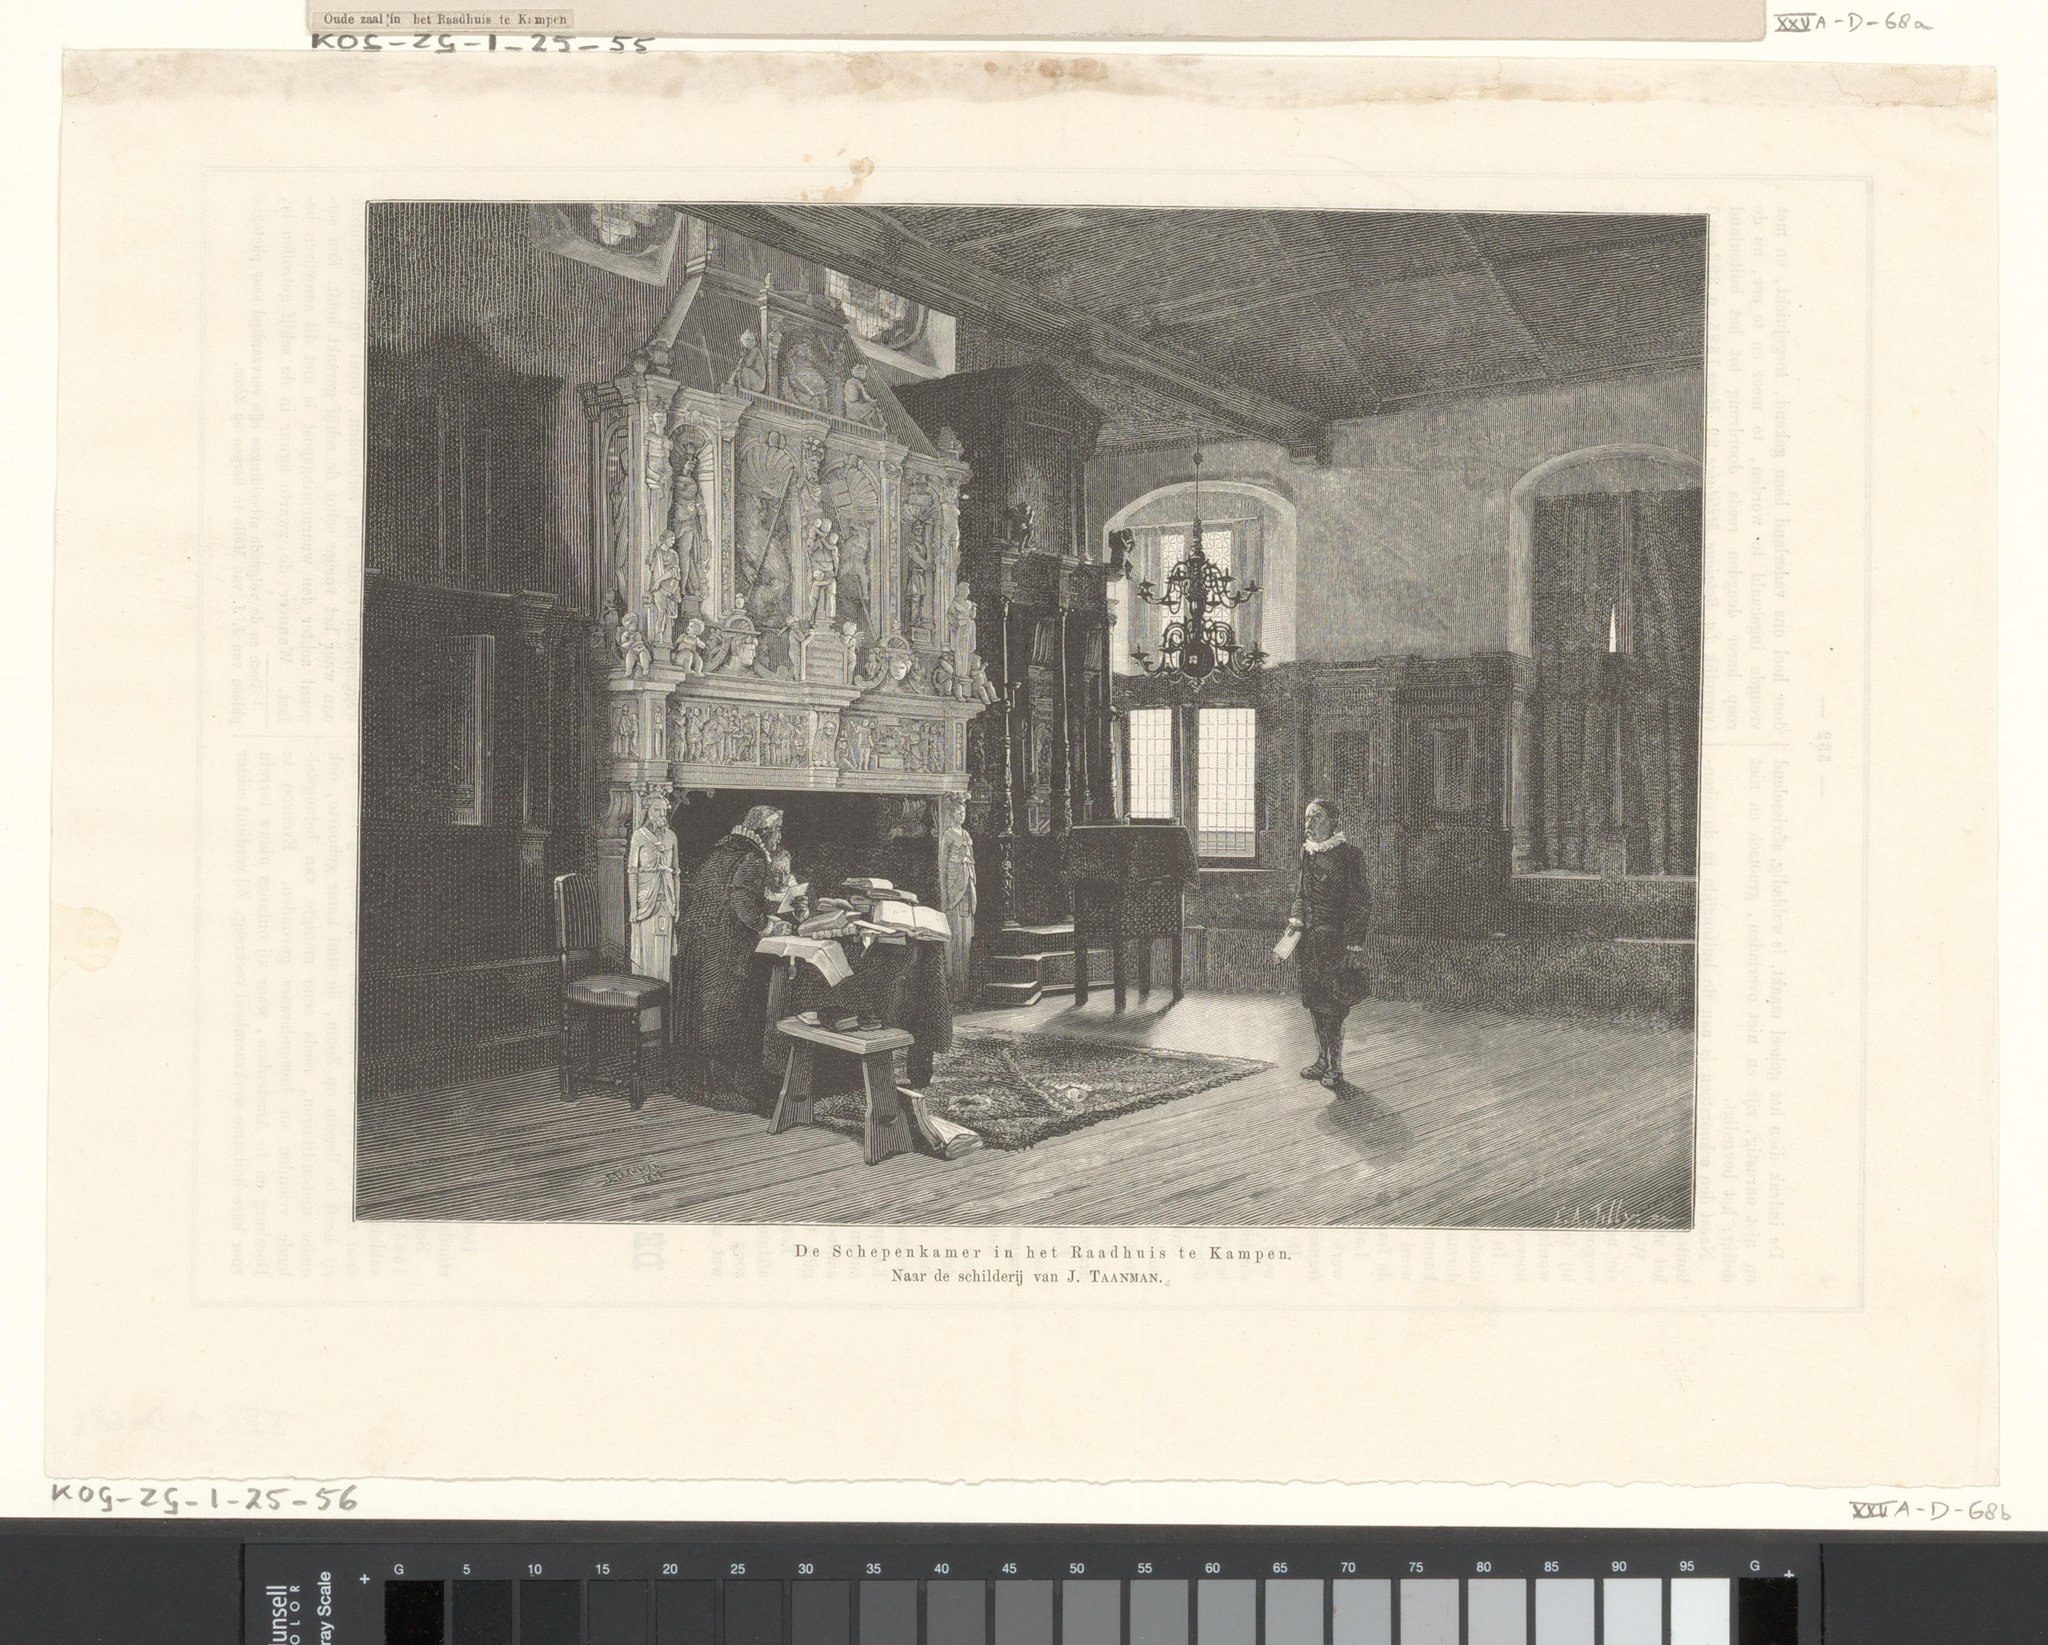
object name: print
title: Schepenzaal in het stadhuis te Kampen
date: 1878-1898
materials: paper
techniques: letterpress printing, engraving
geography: haarlem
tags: townhall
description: Onderwerpsrubrieken binnen de Atlas Zeden en Gewoonten: Zeden en Gewoonten in Engeren Zin, De Woning, Binnenhuizen, Schoorsteenen.